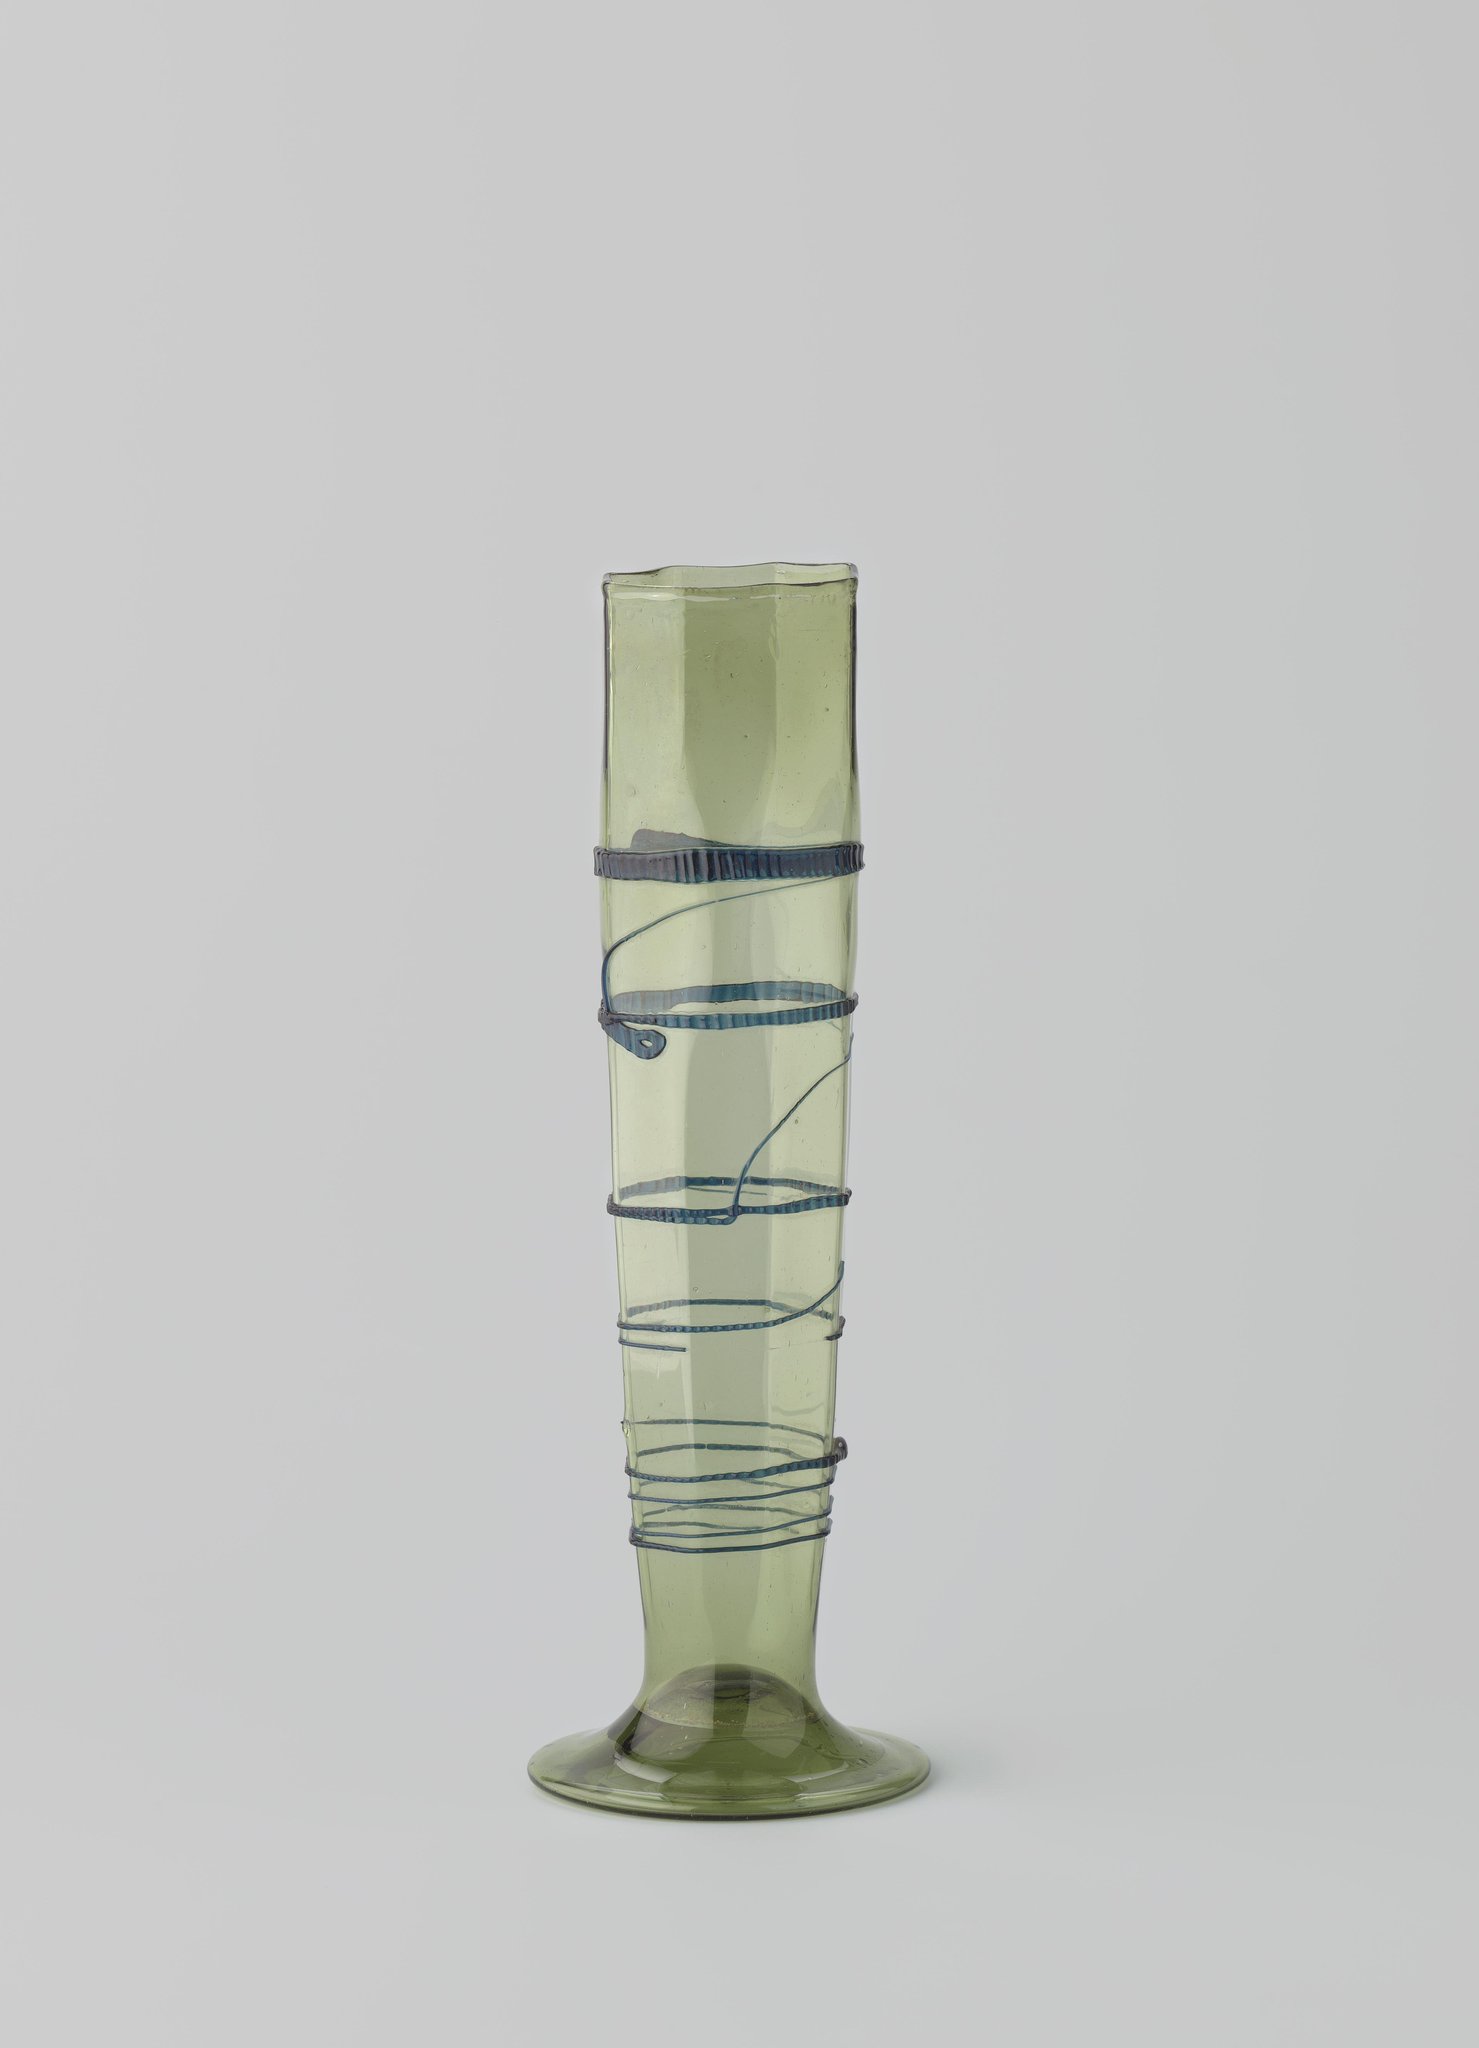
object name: stangenglas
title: Passglas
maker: Anonymous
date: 1600-1699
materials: glass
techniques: glassblowing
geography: germany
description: The German name for this type of glass comes from the rings of glass (passen) that indicate the measures. The trick was to drink precisely from one ring to the next in one gulp. Failing that, the drinker had to try again until he succeeded.